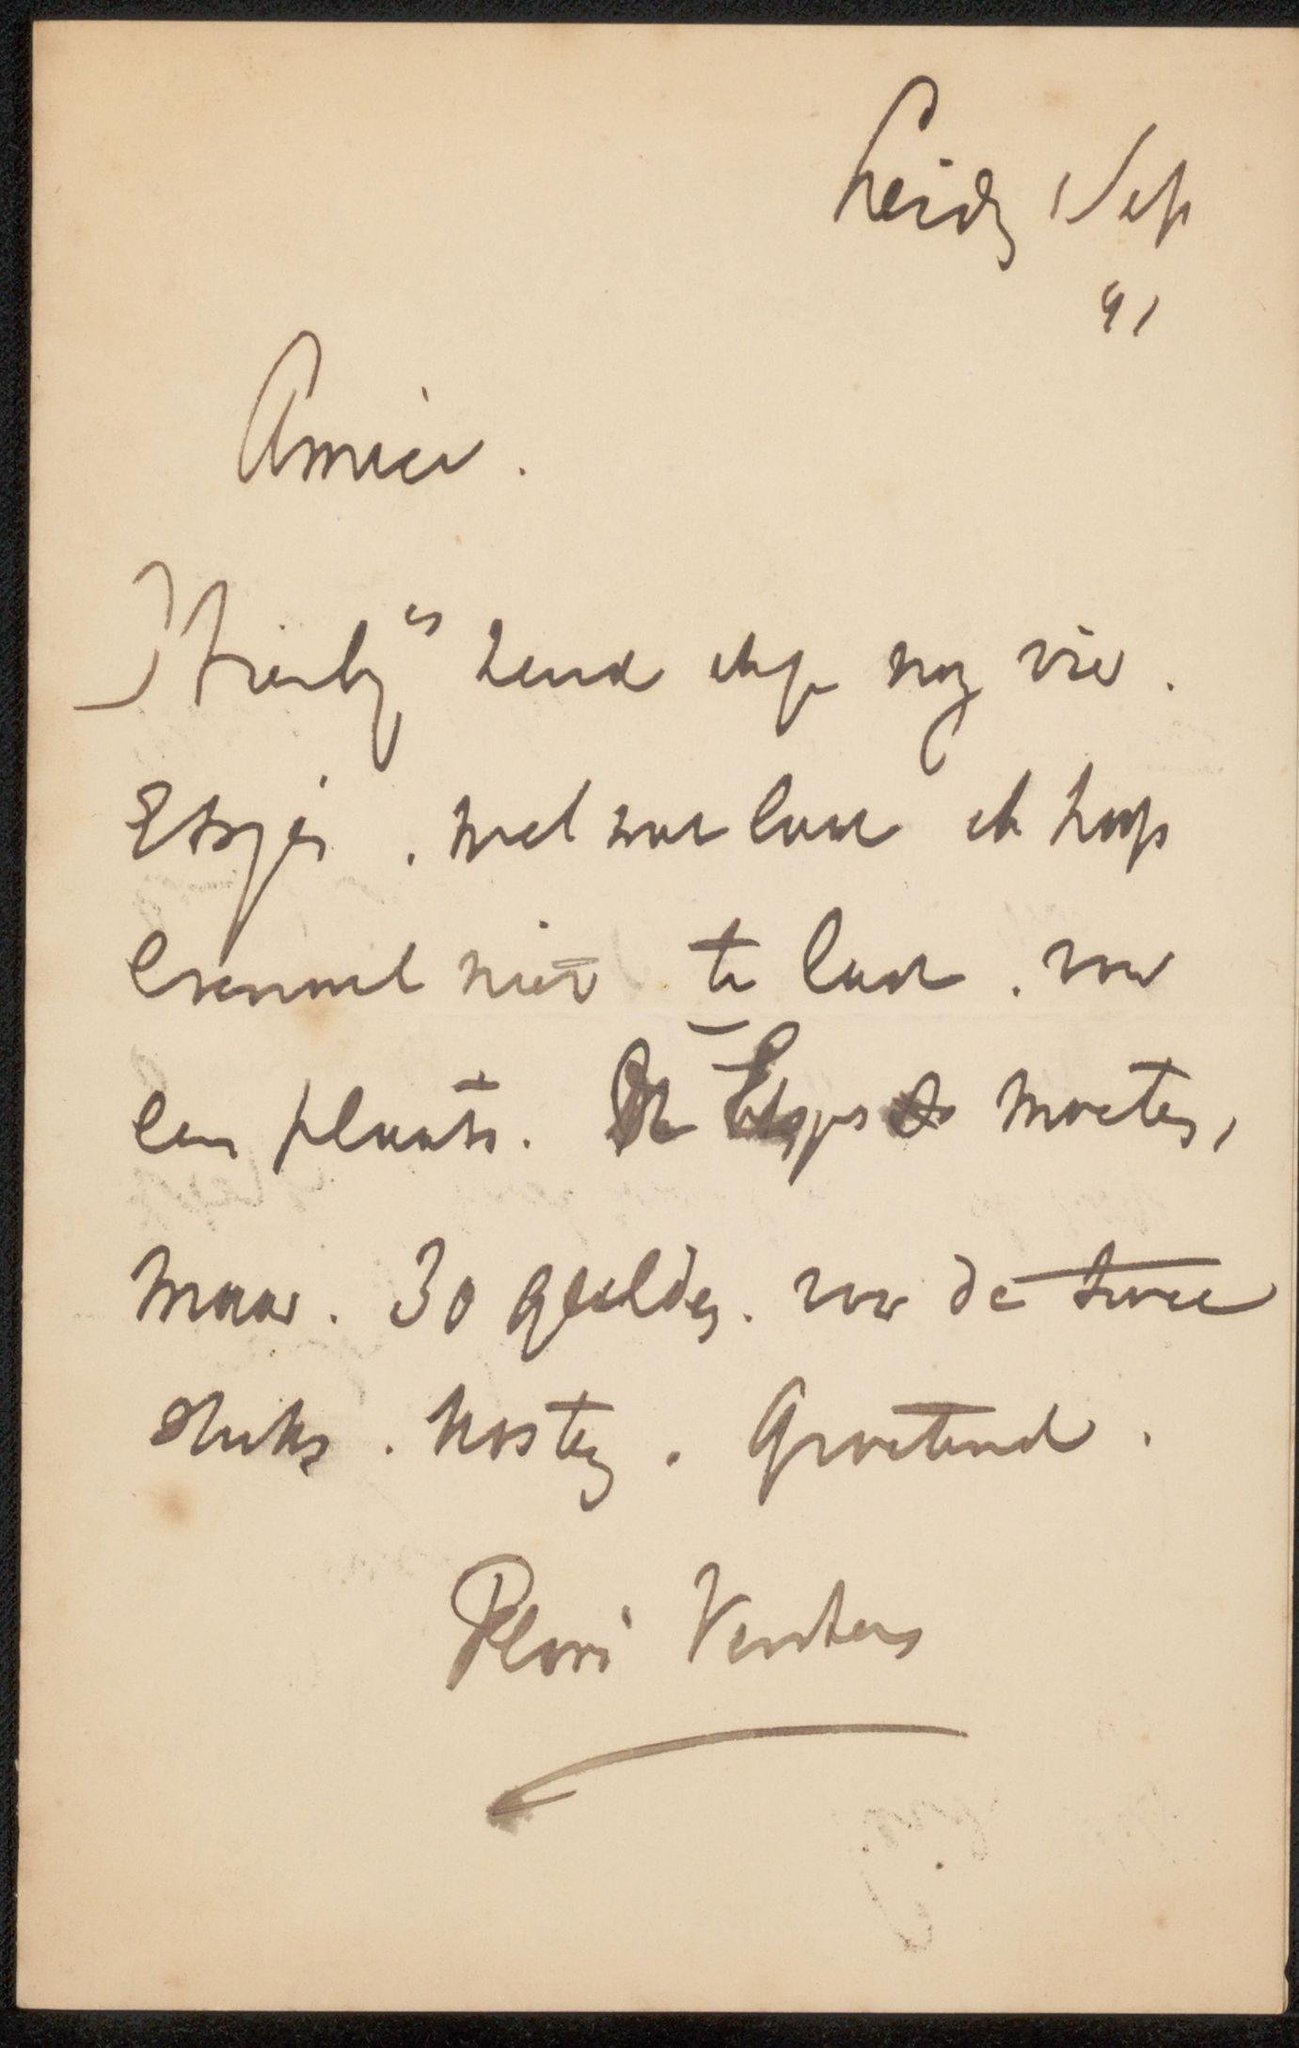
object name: letter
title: Brief aan Philip Zilcken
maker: floris verster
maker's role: draughtsman, painter, print maker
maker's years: 1861-1927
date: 1891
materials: ink, paper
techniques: pen, writing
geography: leiden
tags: the hague, painter, philip zilcken, the graphic arts, money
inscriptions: collector's mark: ‘RPK’